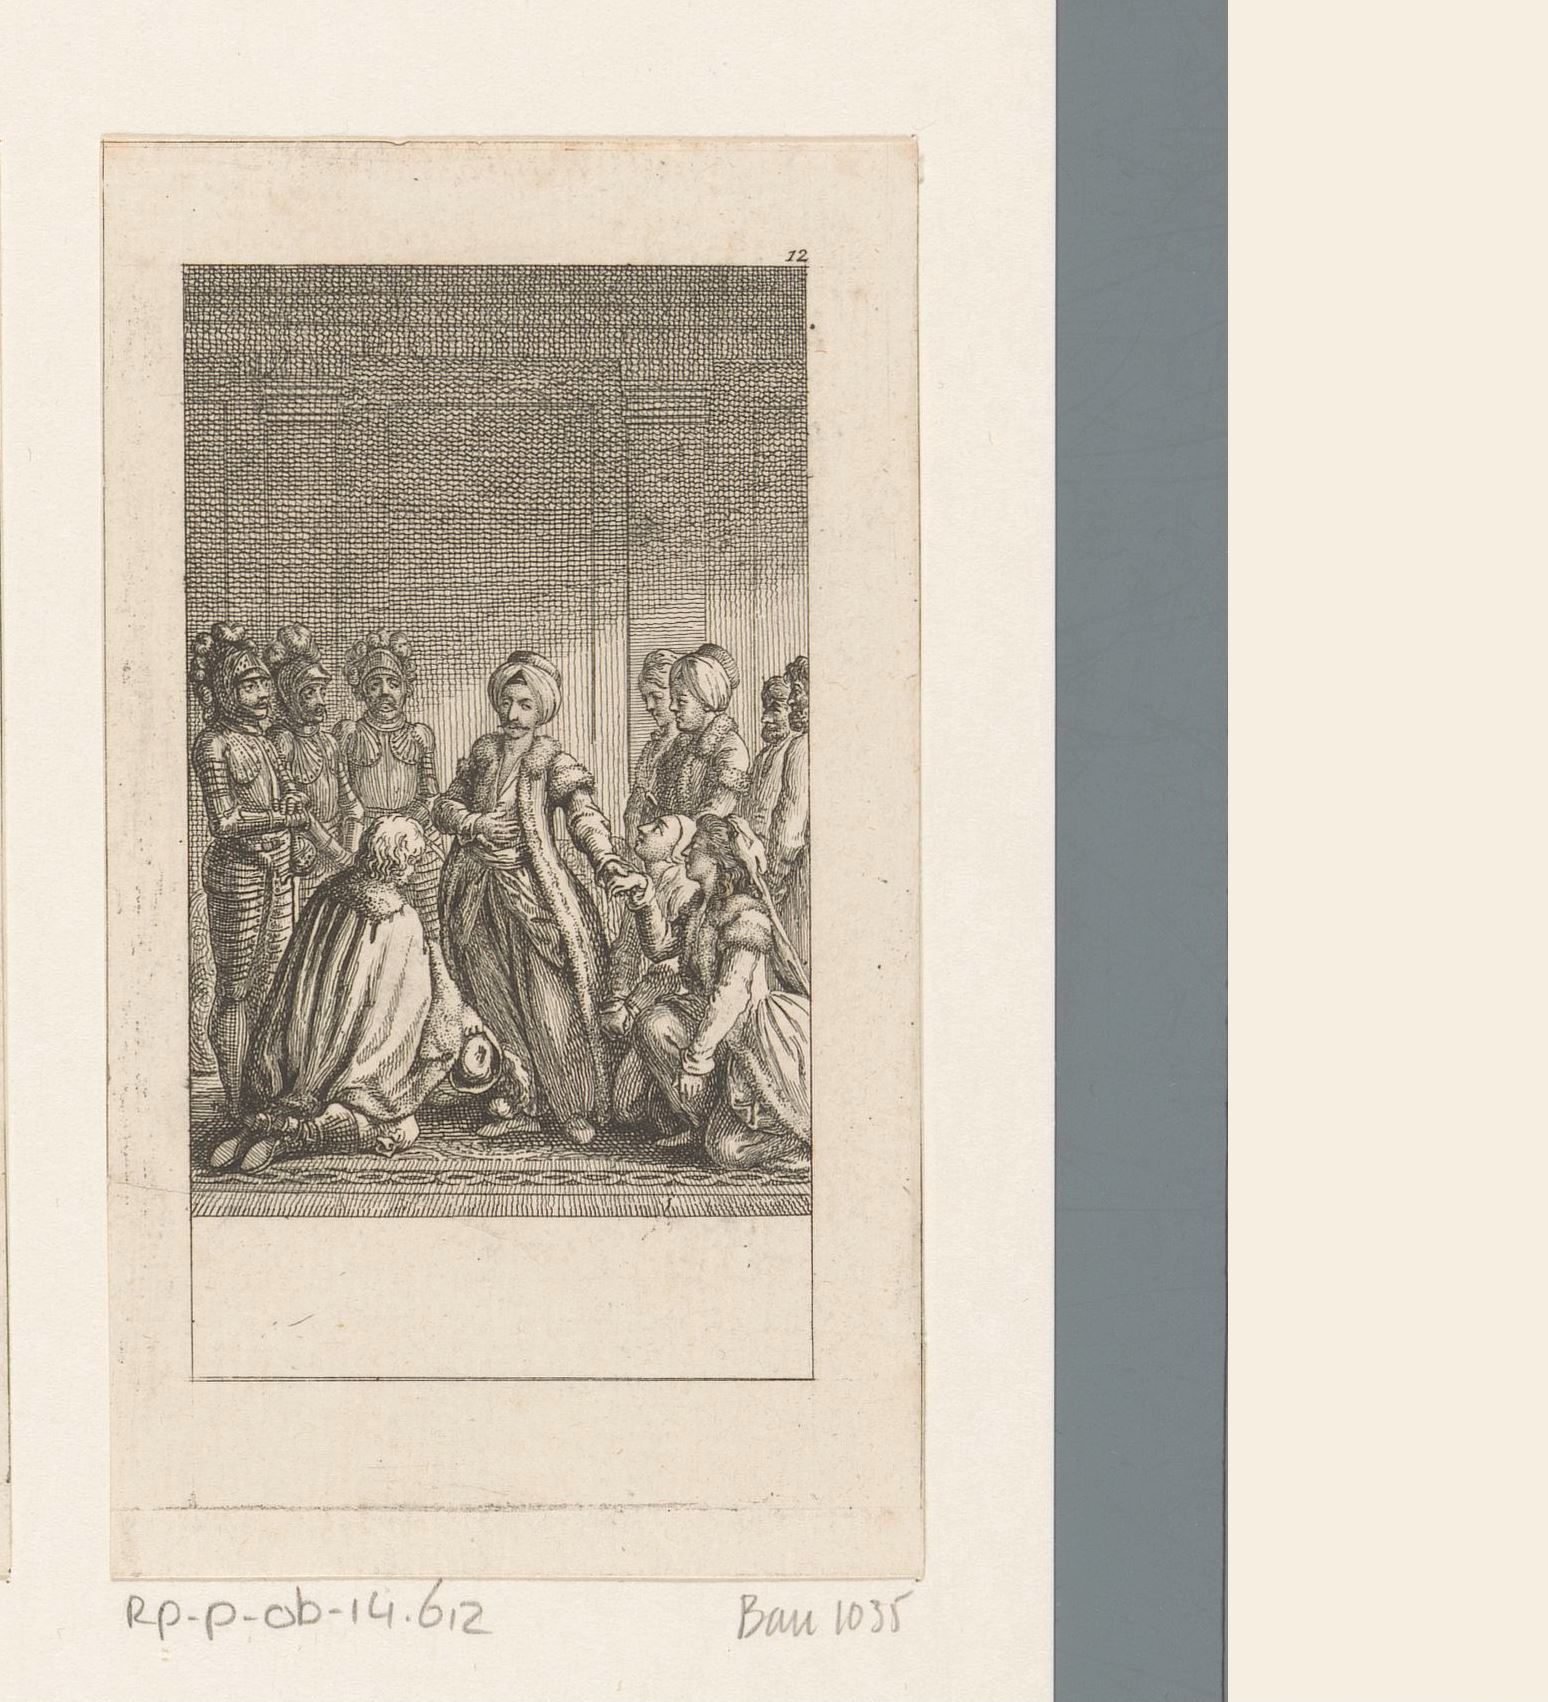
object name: print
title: Bassa laat Karl, Adelheid en haar vader vrij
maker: daniel nikolaus chodowiecki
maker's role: draughtsman, print maker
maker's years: 1726-1801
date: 1783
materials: paper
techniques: etching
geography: berlin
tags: berlin, literature, head-gear: turban, interior of the house, kneeling figure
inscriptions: collector's mark: Lugt 2228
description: Vervaardigd voor G. F. W. Grossmann's 'Adelheid von Veltheim'. Een latere staat gebruikt in: Königlich Grosbritannischer genealogischer Kalender auf das Jahr 1784. Lauenburg: Berenberg, 1783.